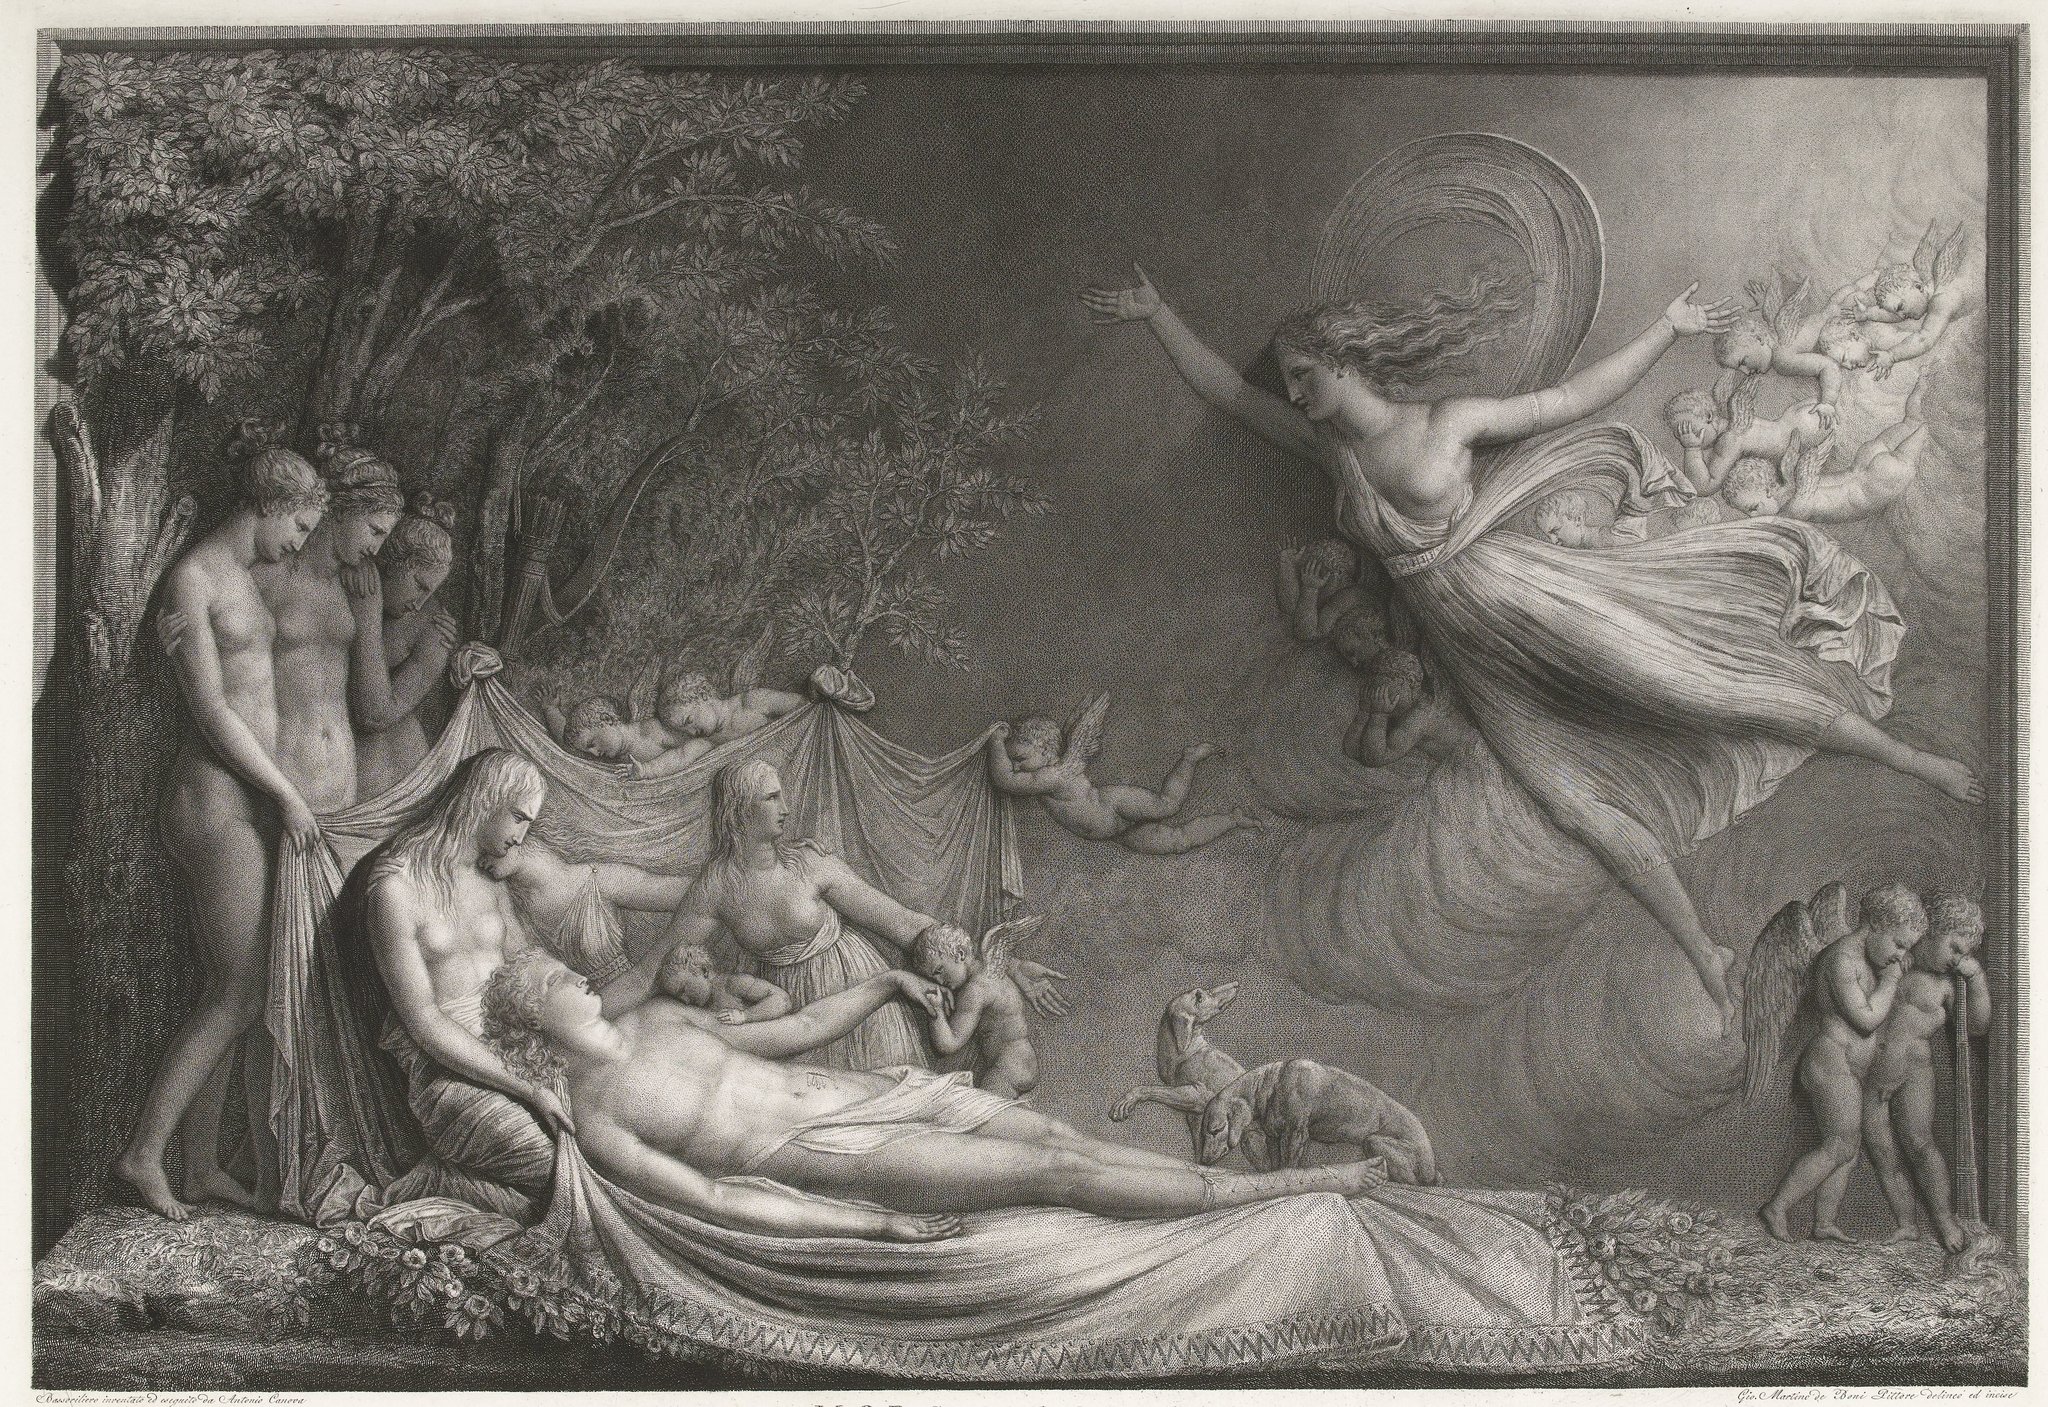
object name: print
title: The Death of Adonis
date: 1800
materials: paper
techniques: etching, engraving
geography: rome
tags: death of adonis: he is killed by a boar, adonis' blood changed into an anemone or a rose: when adonis is slain by a boar, venus changes his blood into an anemone or a rose (ovid, metamorphoses x 735)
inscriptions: date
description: This print and the adjacent pendant represent two marble reliefs, which are now in the Museo Canova in Possagno. Depicted is the goddess Venus swooping down upon her beloved Adonis. The young mortal has just been killed while hunting and is mourned by his dogs, several nymphs, and the god of love Cupid. The interplay of light and shadow lend the print an extraordinary sense of depth.